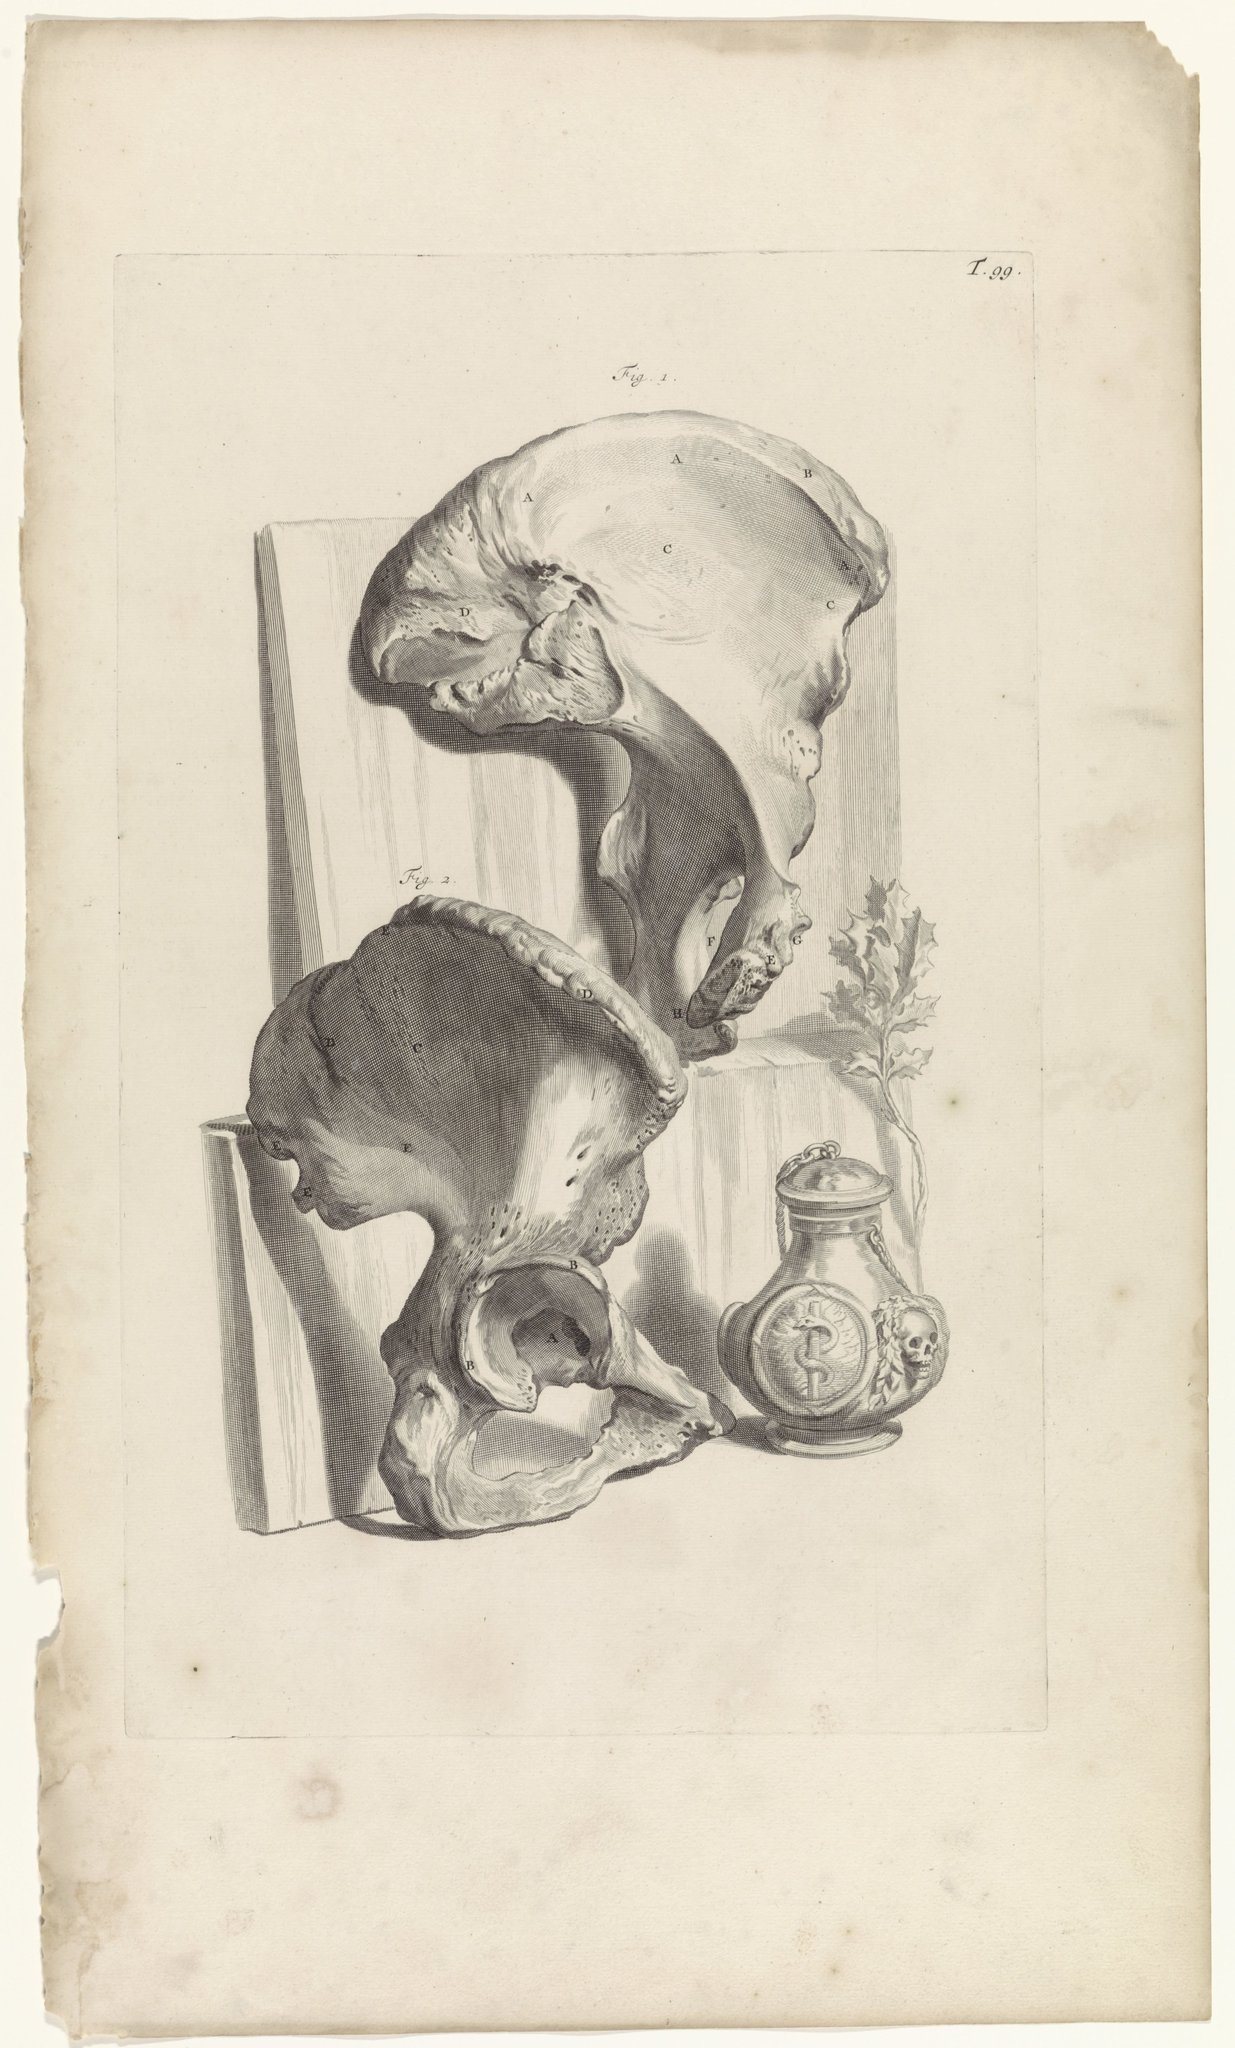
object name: print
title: Anatomische studie van de heup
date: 1685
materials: paper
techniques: engraving, etching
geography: amsterdam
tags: pelvis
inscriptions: collector's mark: Lugt 2228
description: Boekillustratie voor Bidloo, Godefridus. Anatomia humani corporis centum & quinque tabulis, per art. G. de Lairesse ad vivum delineatis, de monstrata, veterum recentiorumque inventis explicata plurimisque, hactenus non detectis, illustrata. Amsterdam: Weduwe Joannes van Someren, Hendrick Boom en erven Dirk Boom, 1685.